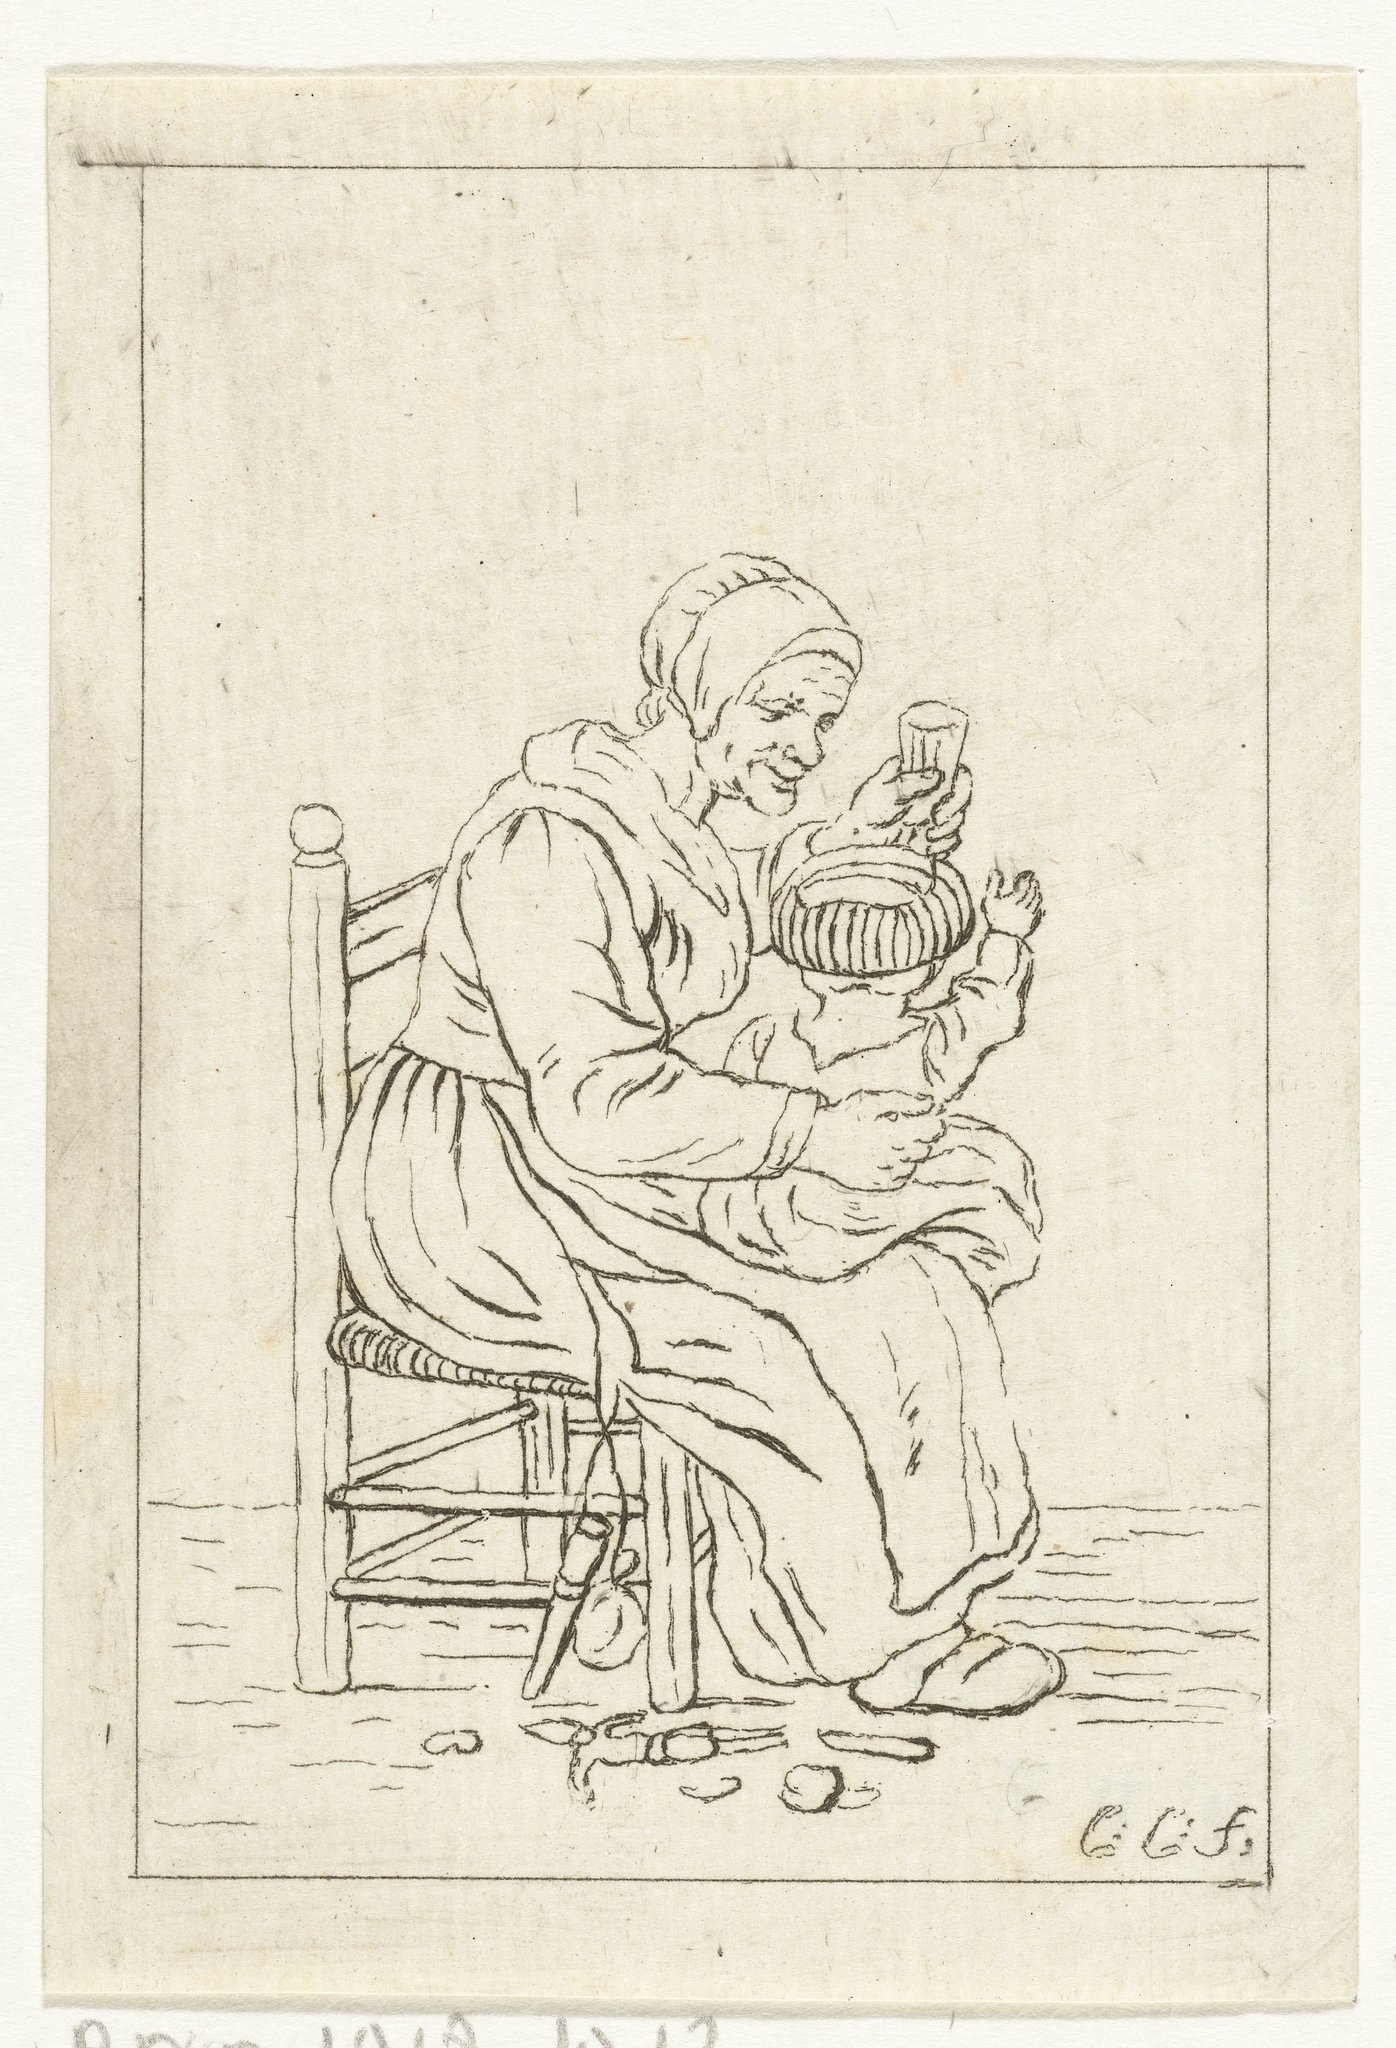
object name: print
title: Vrouw met kind op schoot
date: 1779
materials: paper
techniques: etching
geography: leiden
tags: mother and baby or young child, (playing with) toys, drinking, mother and child(ren), woman and child(ren) (family group) (with number of children)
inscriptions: collector's mark: Lugt 2233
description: Moeder met kind op de schoot. Ze probeert het kind uit een beker te laten drinken. Op de grond wat speelgoed. Profiel naar rechts.